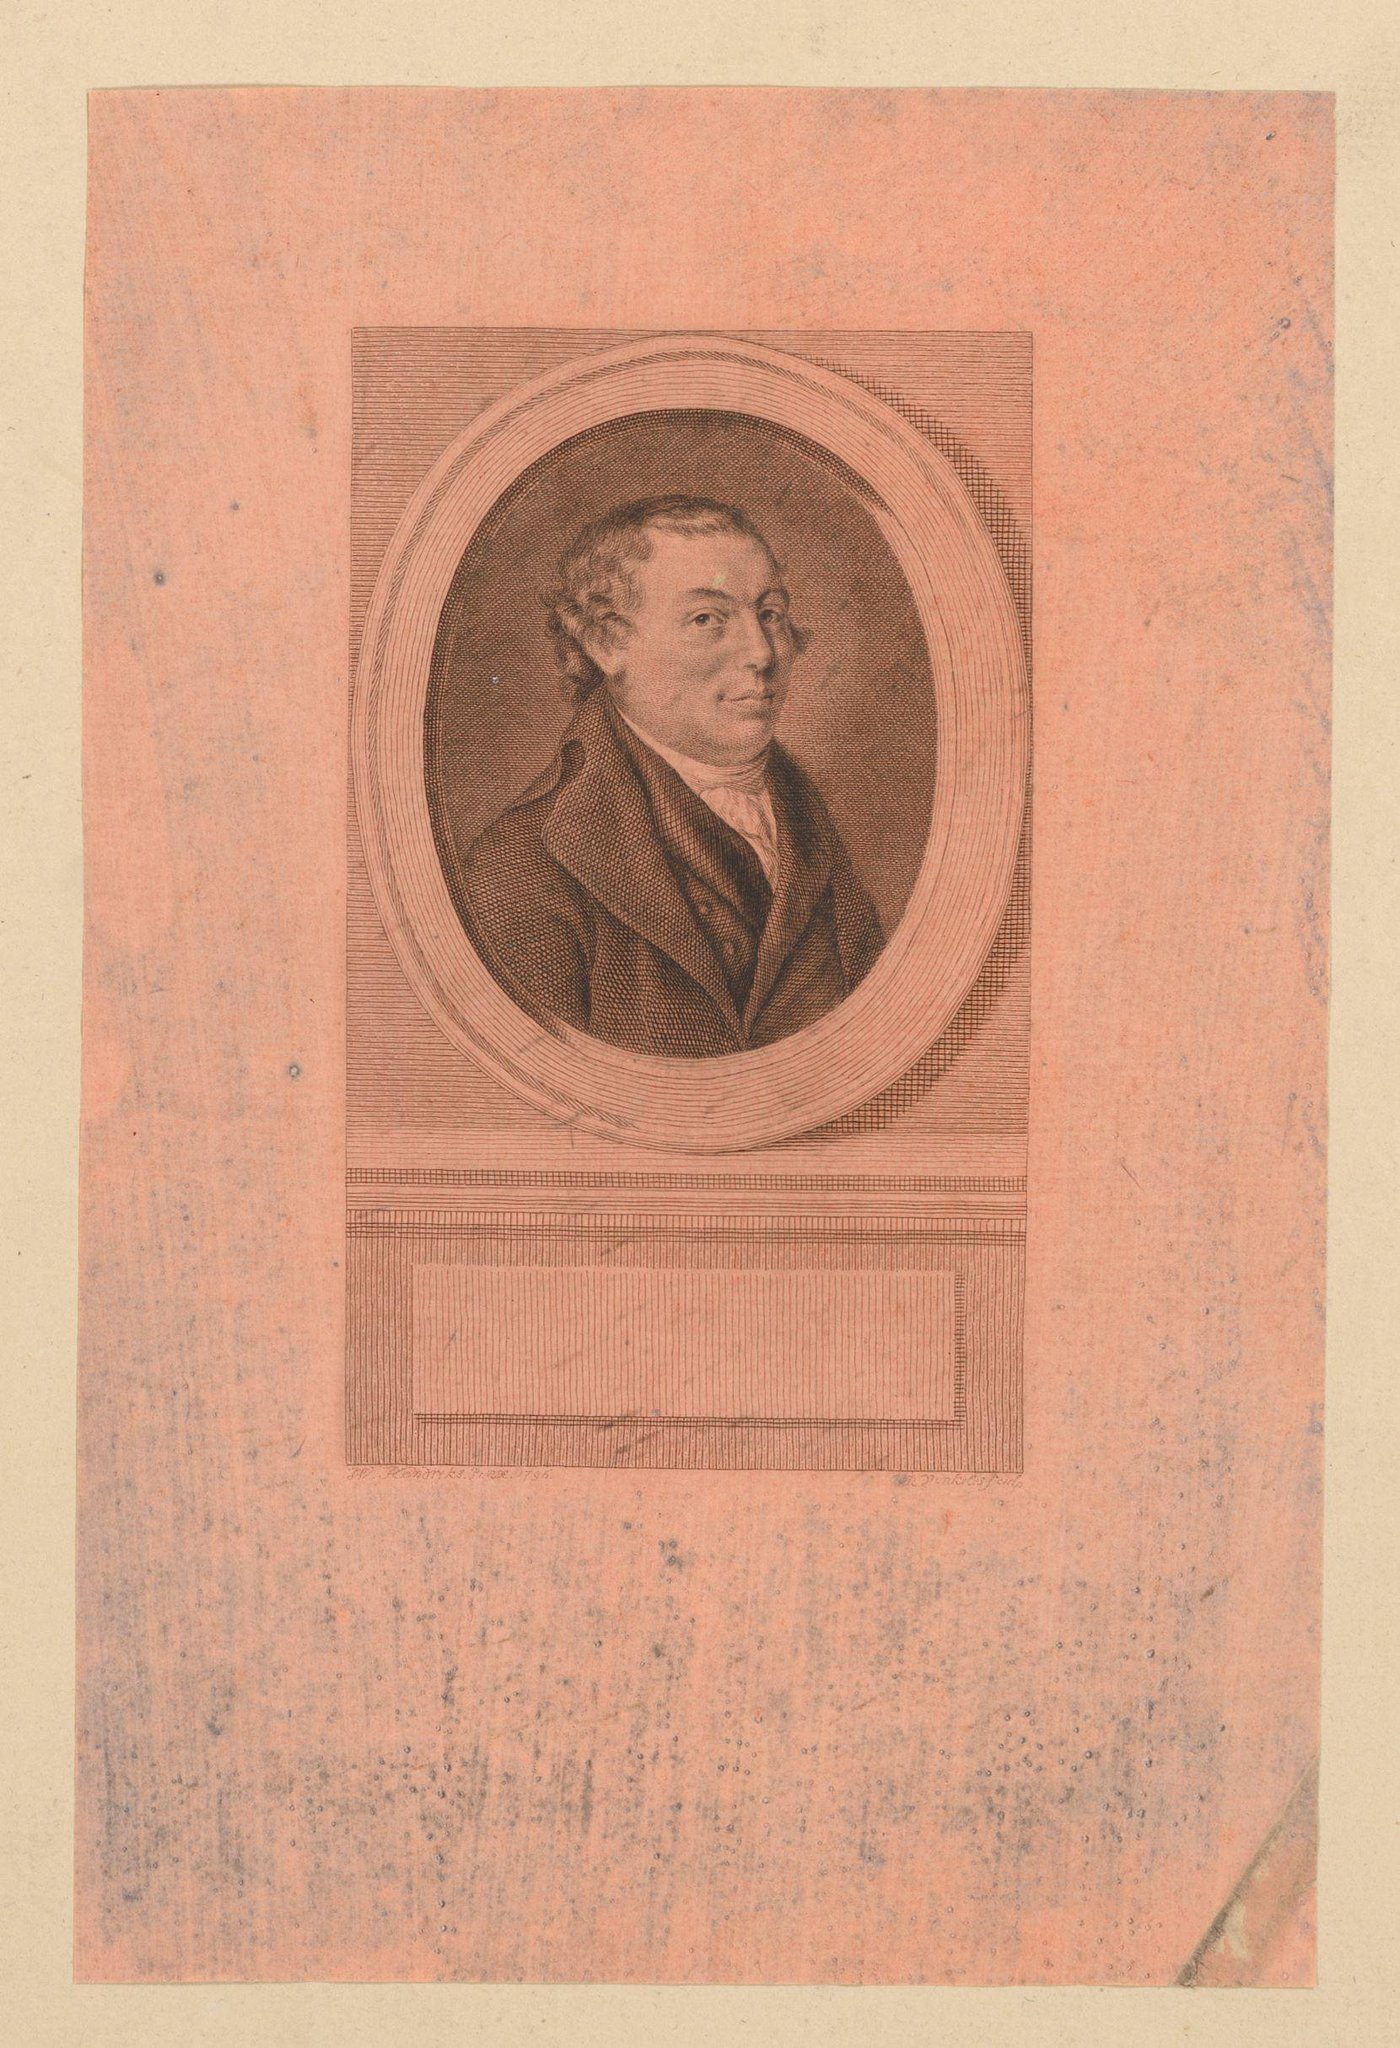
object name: print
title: Portret van Adriaan Pietersz. Loosjes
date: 1796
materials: paper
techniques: engraving, etching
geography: amsterdam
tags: haarlem, bookseller, adriaan pietersz. loosjes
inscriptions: date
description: Portret van de dichter, schrijver en boekhandelaar Adriaan Pietersz. Loosjes. De prent maakt deel uit van een album.